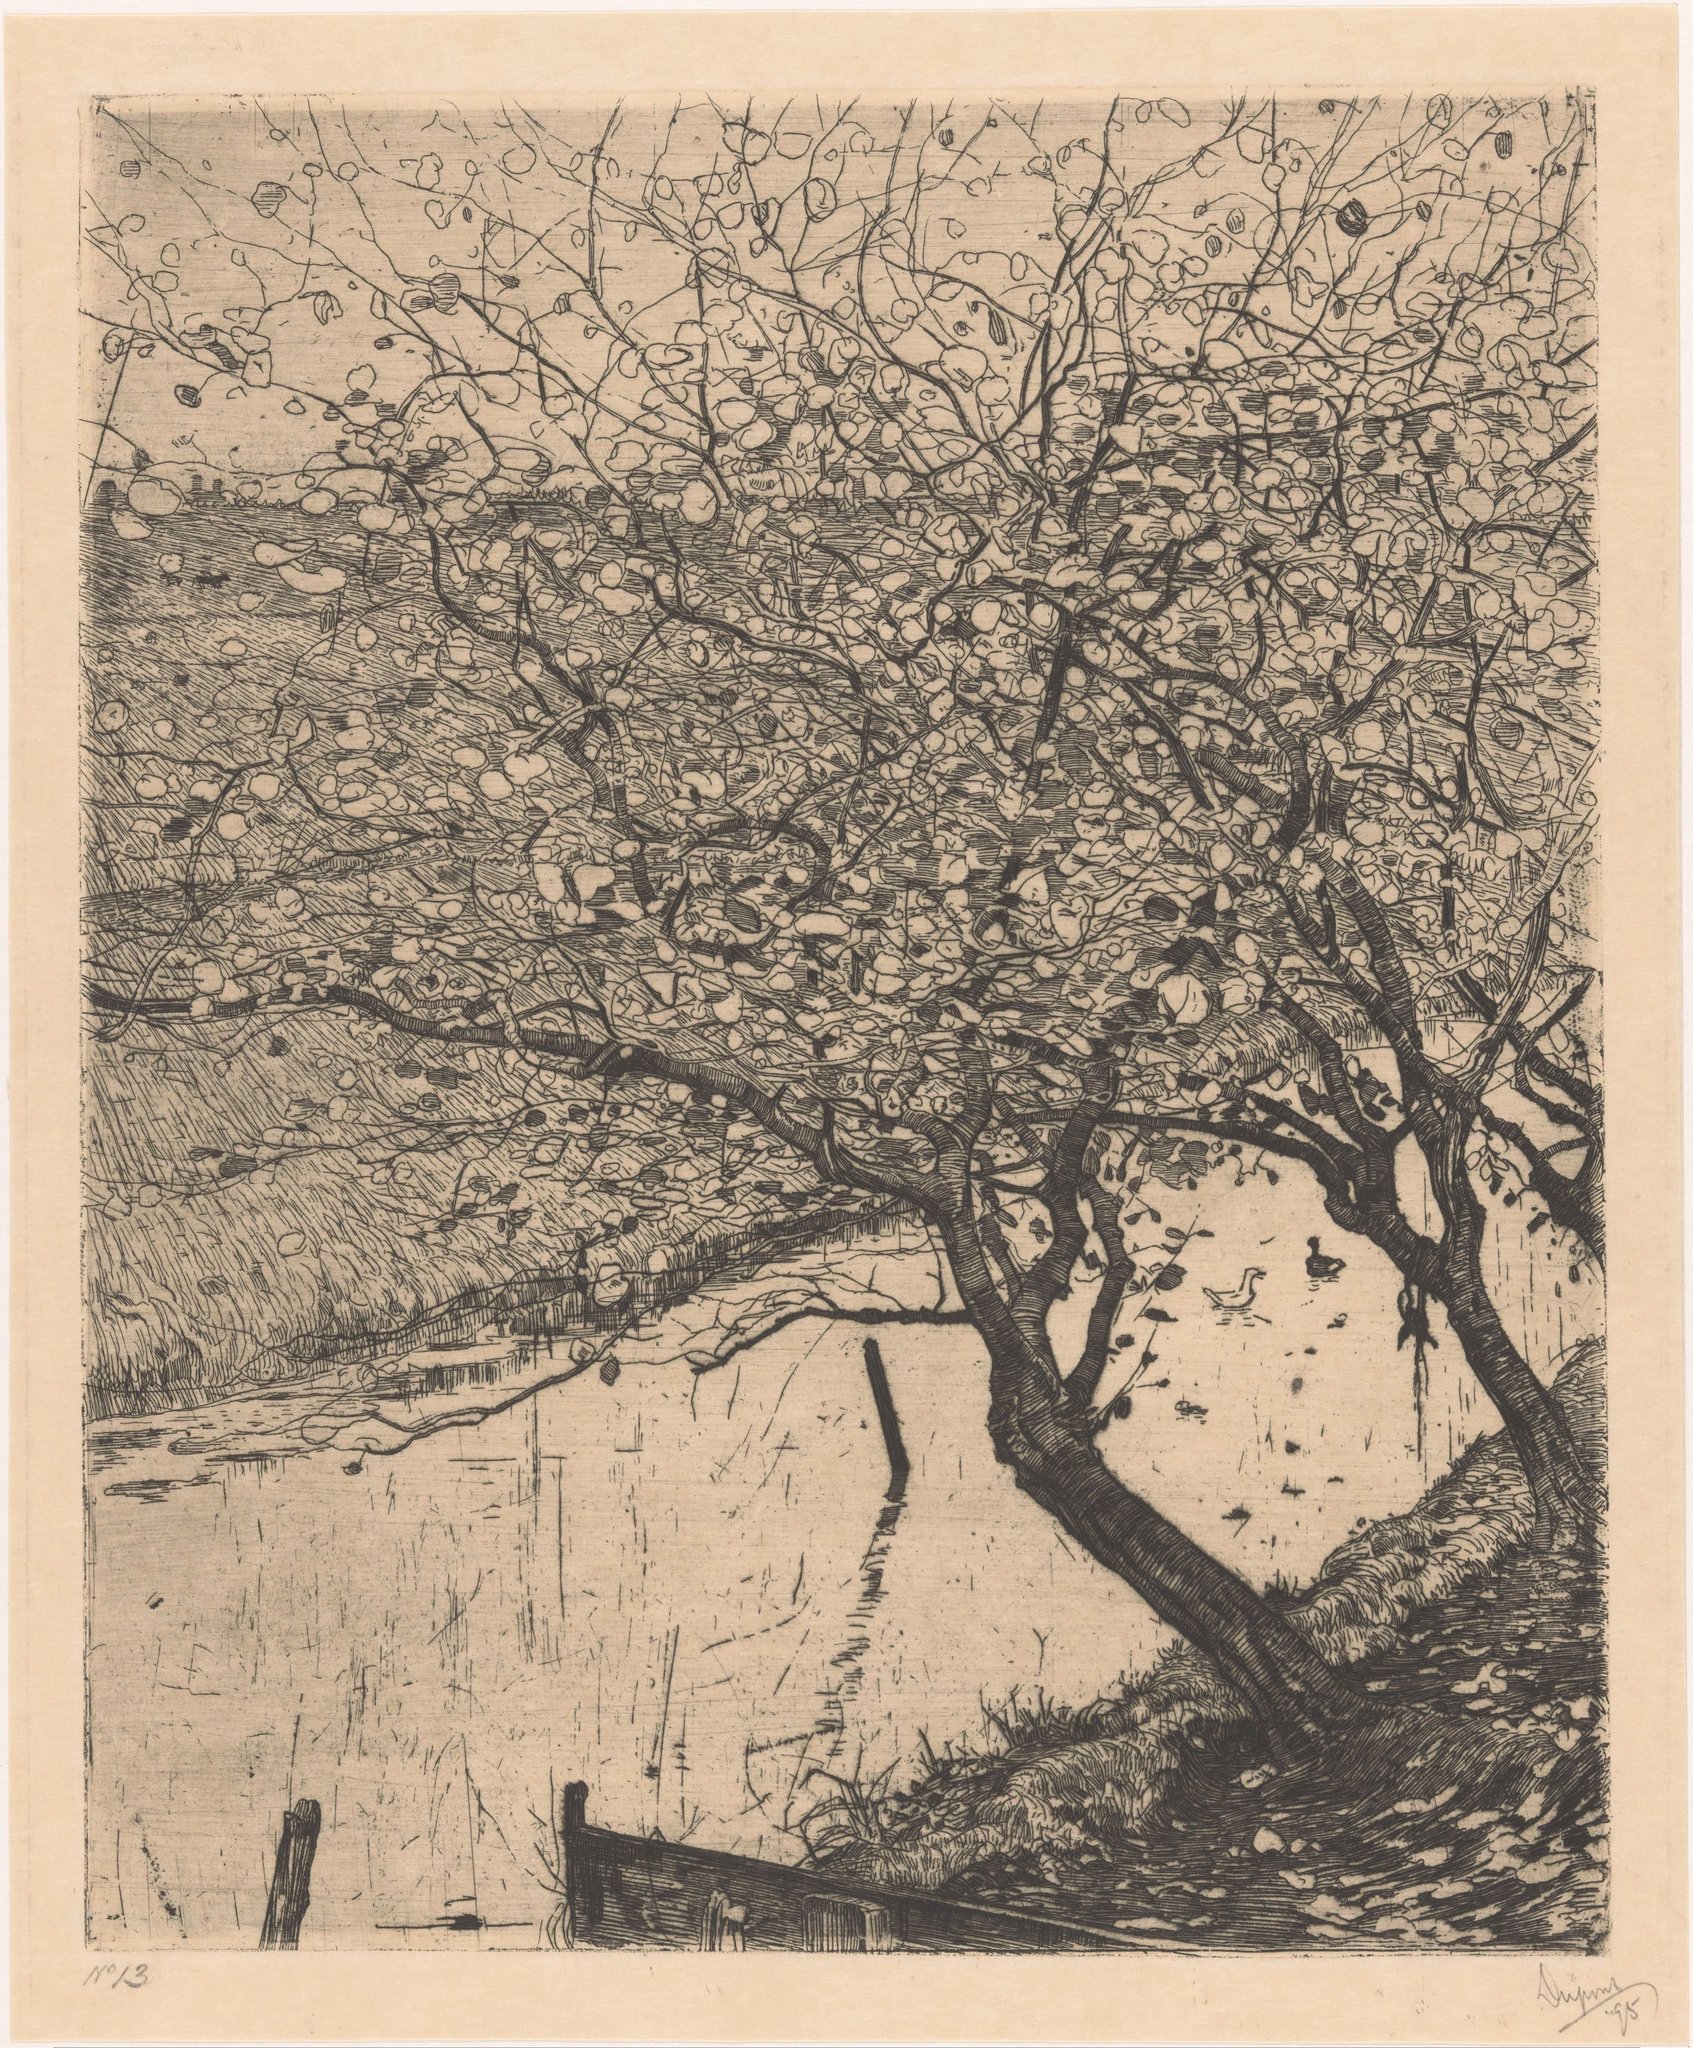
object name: print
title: Scheefgegroeide appelbomen langs een sloot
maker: pieter dupont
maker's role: draughtsman, print maker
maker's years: 1870-1911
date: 1895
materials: paper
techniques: intaglio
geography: north holland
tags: trees: apple-tree, small canal, ditch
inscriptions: number: ‘13’, collector's mark: Lugt 2233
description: In de sloot twee watervogels. Op de achtergrond weilanden.